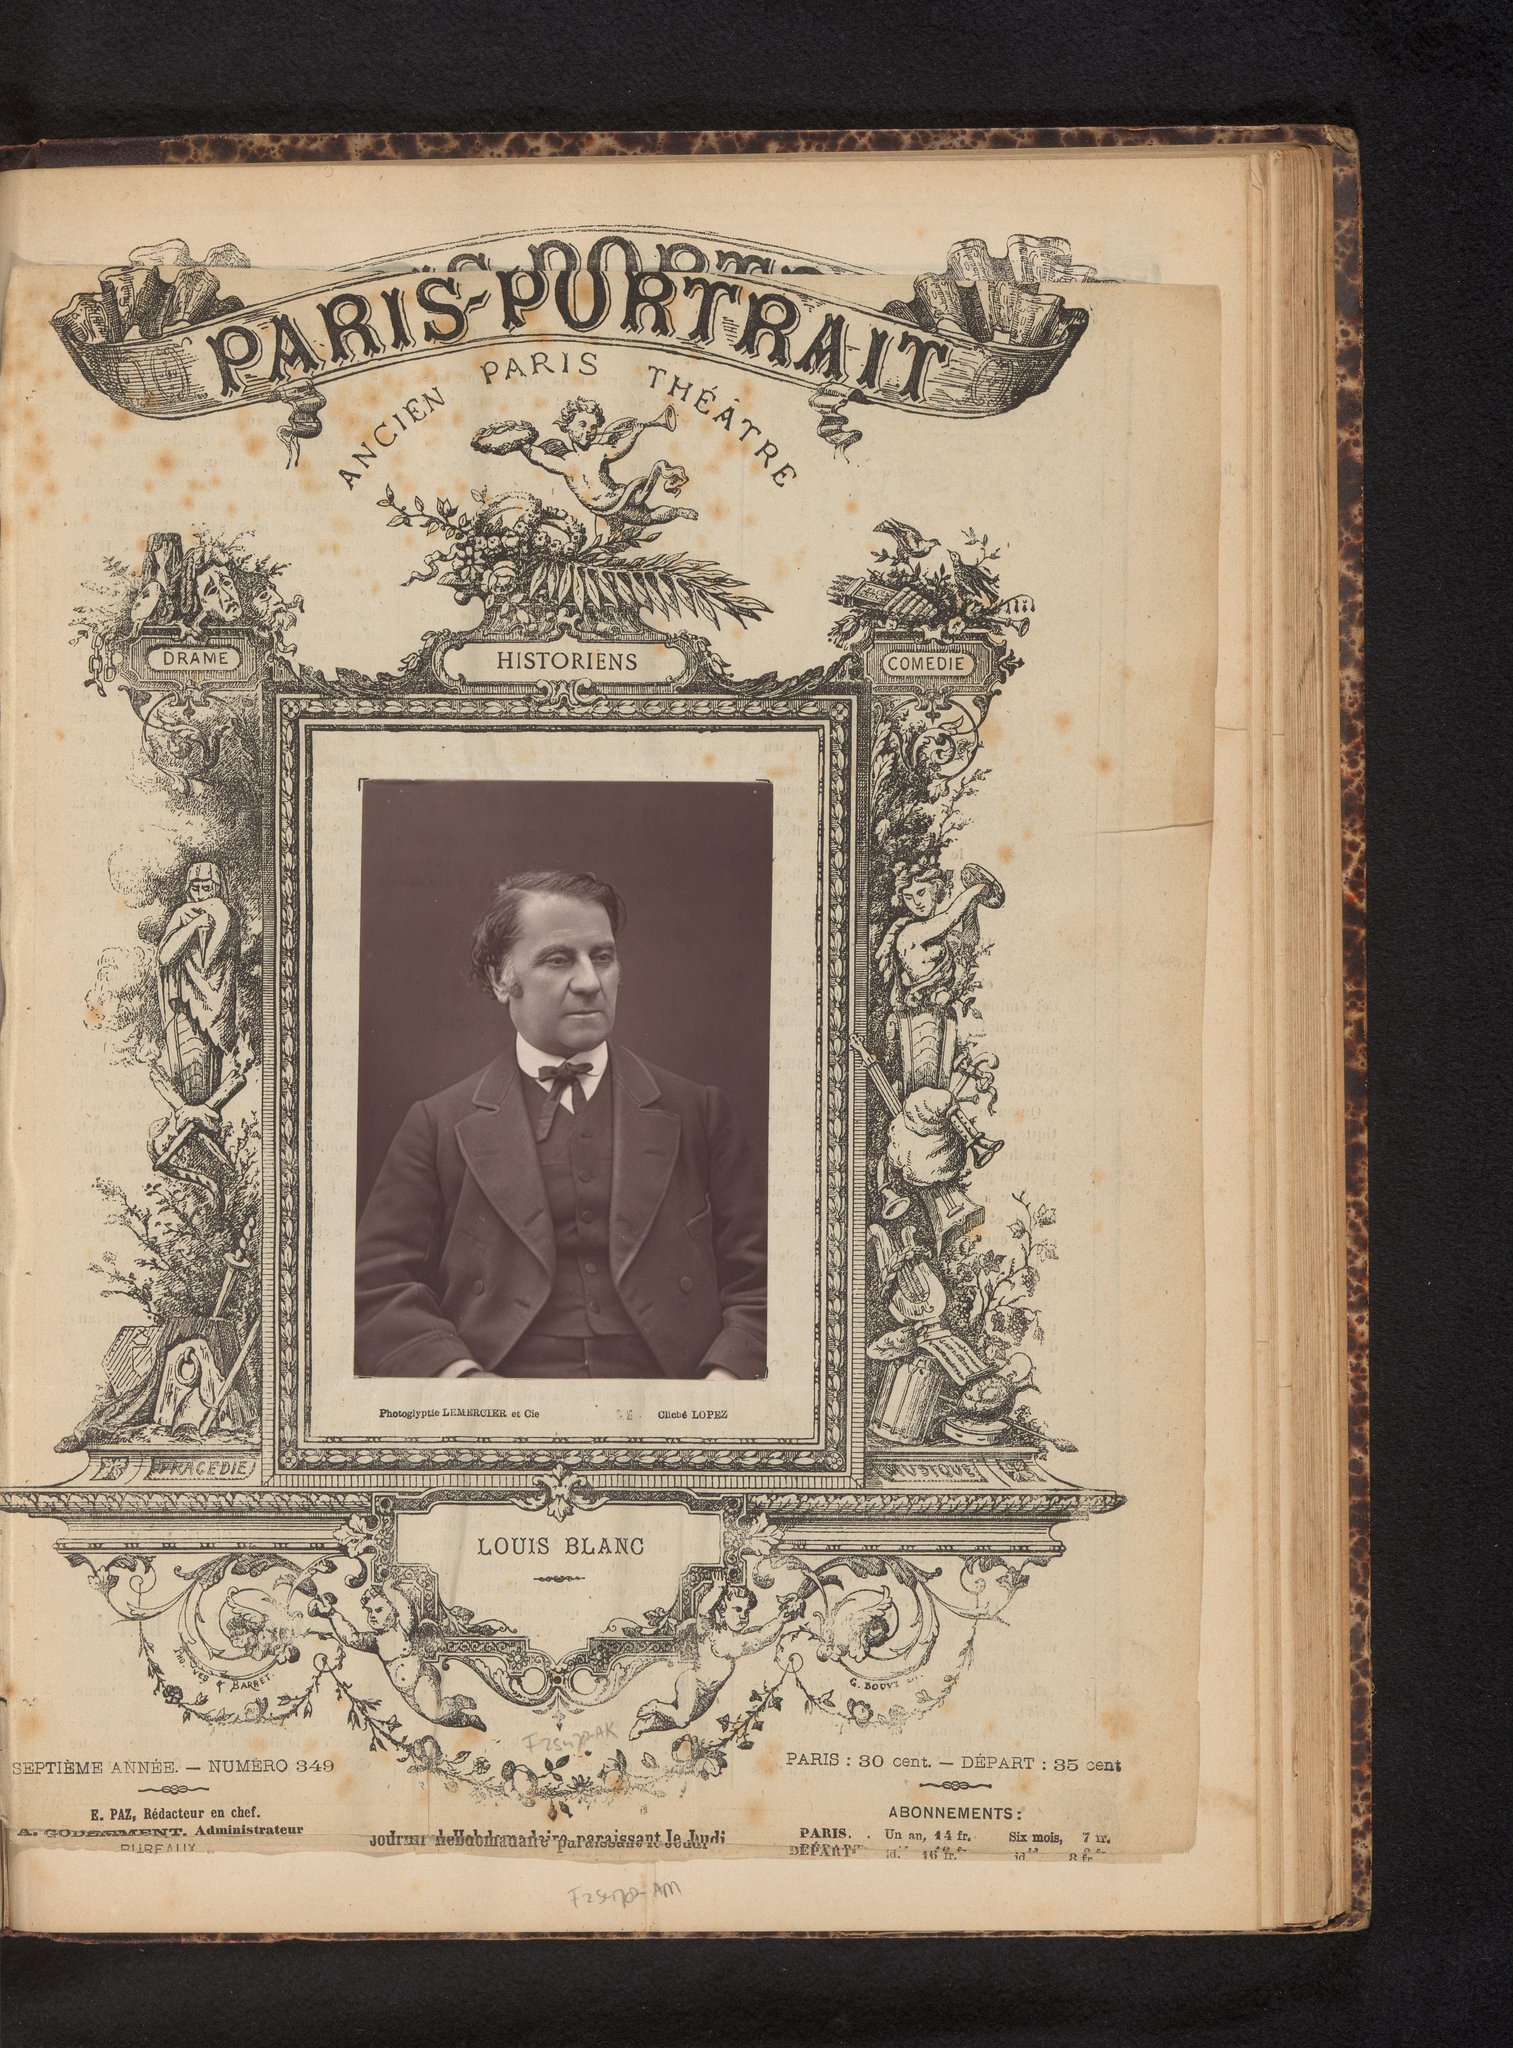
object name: photomechanical print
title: Louis Blanc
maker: lopez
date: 1873-1880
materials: paper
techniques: woodburytype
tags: politician, historical persons